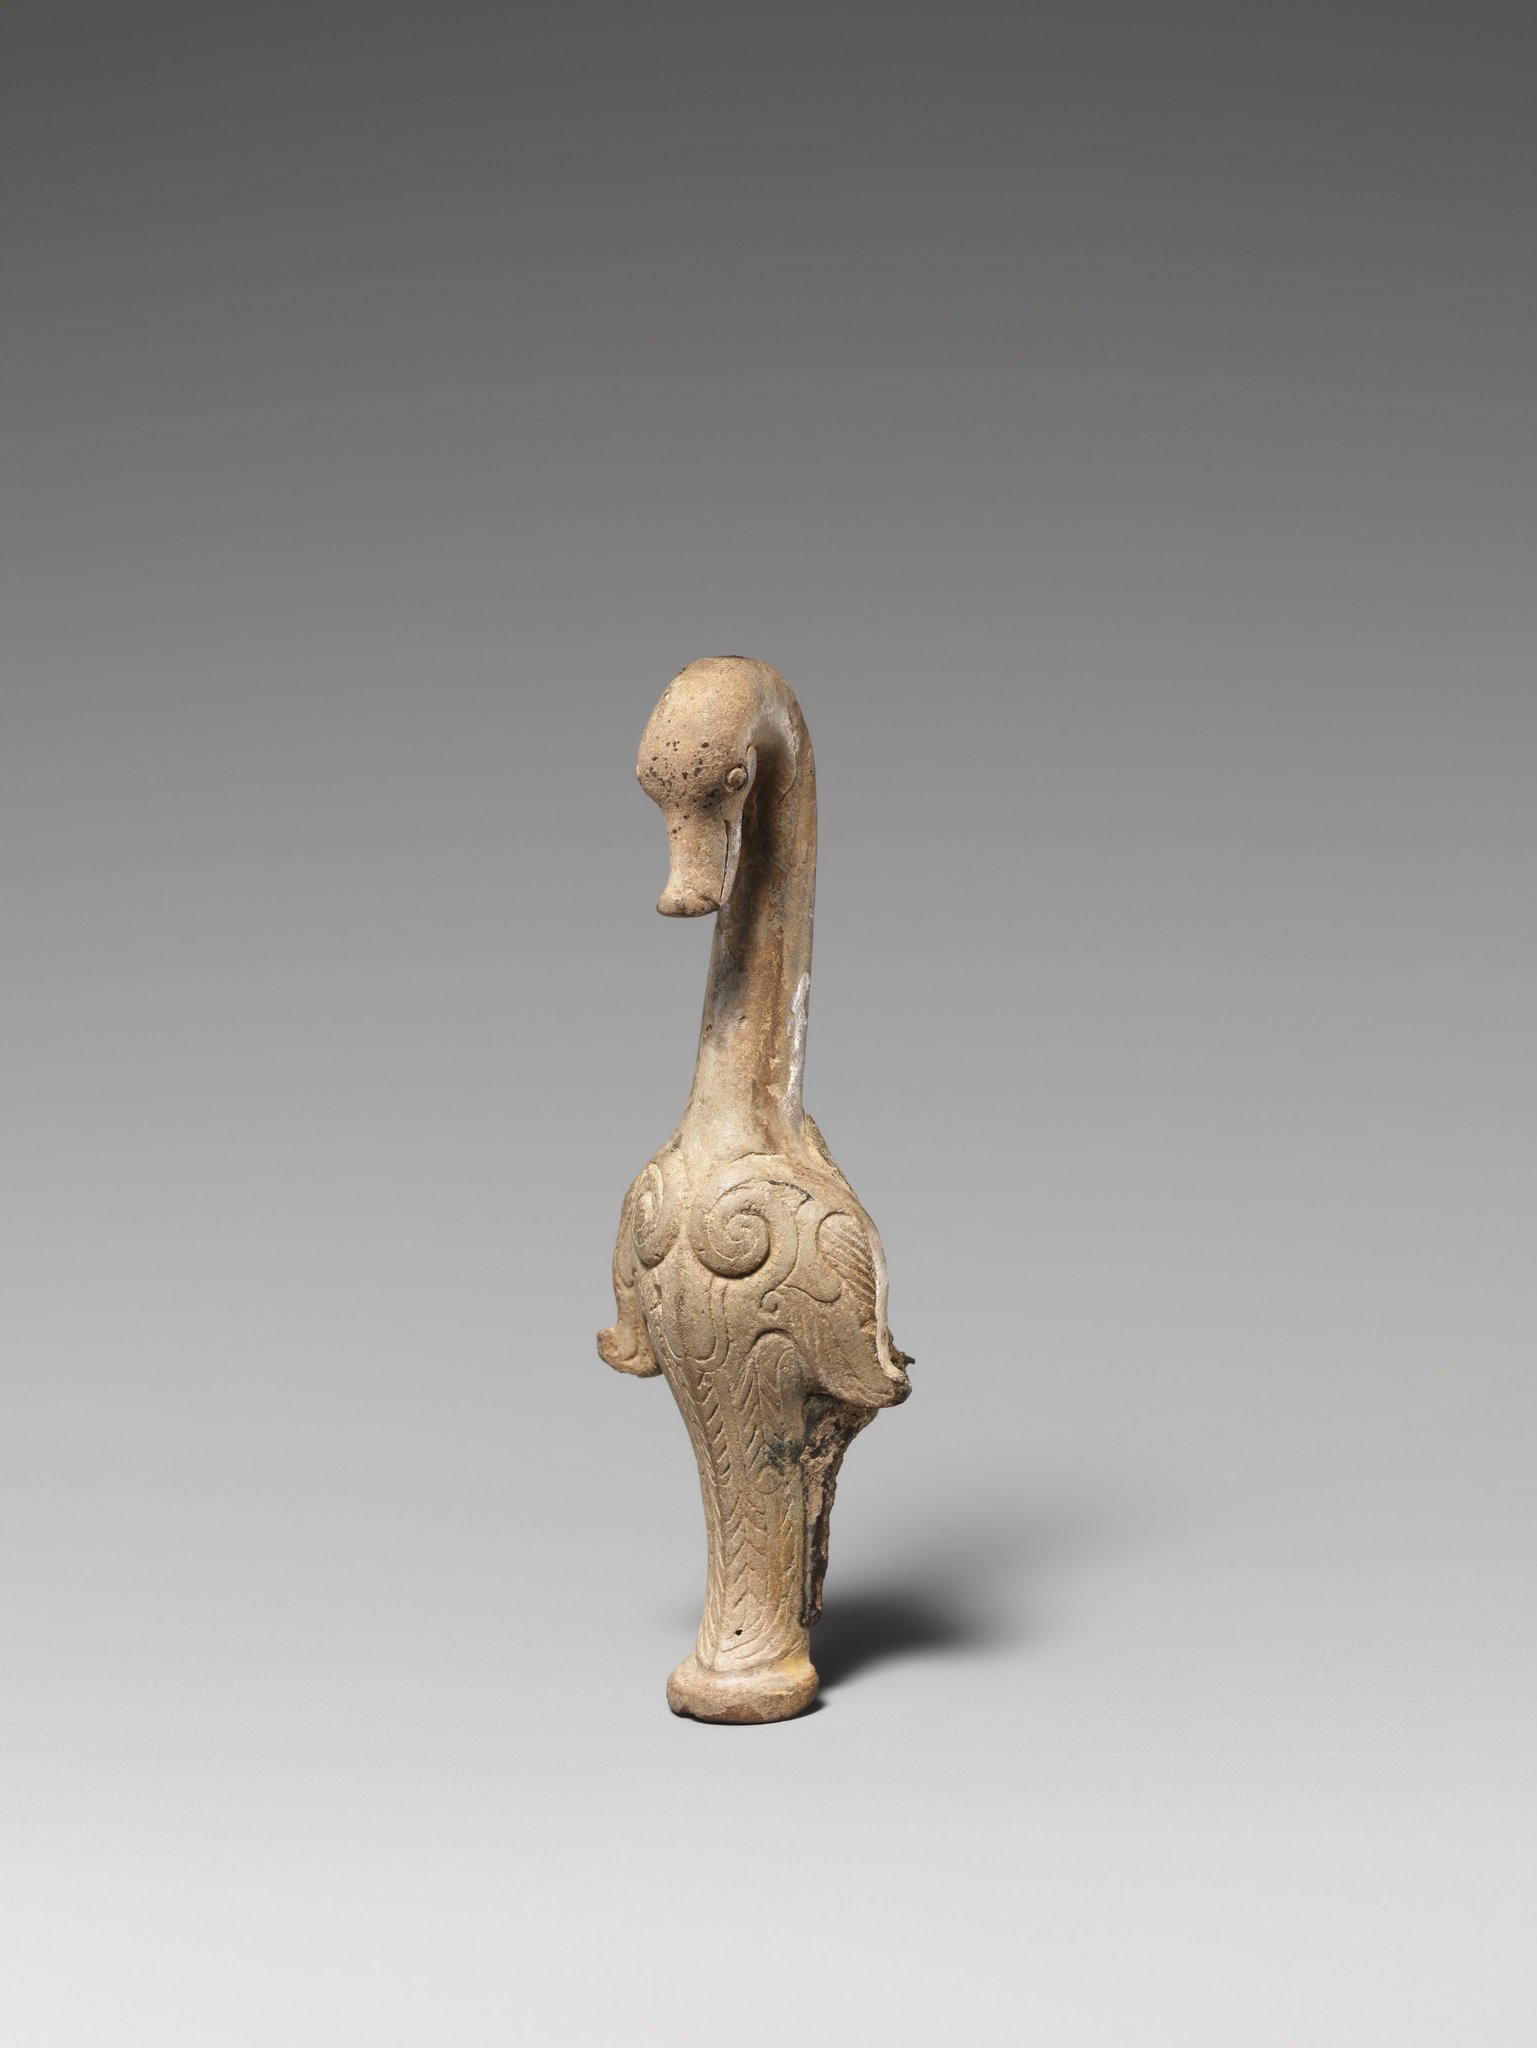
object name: vessel leg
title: Vessel leg in the form of a bird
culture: chinese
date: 500-201 BCE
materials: bronze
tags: birds